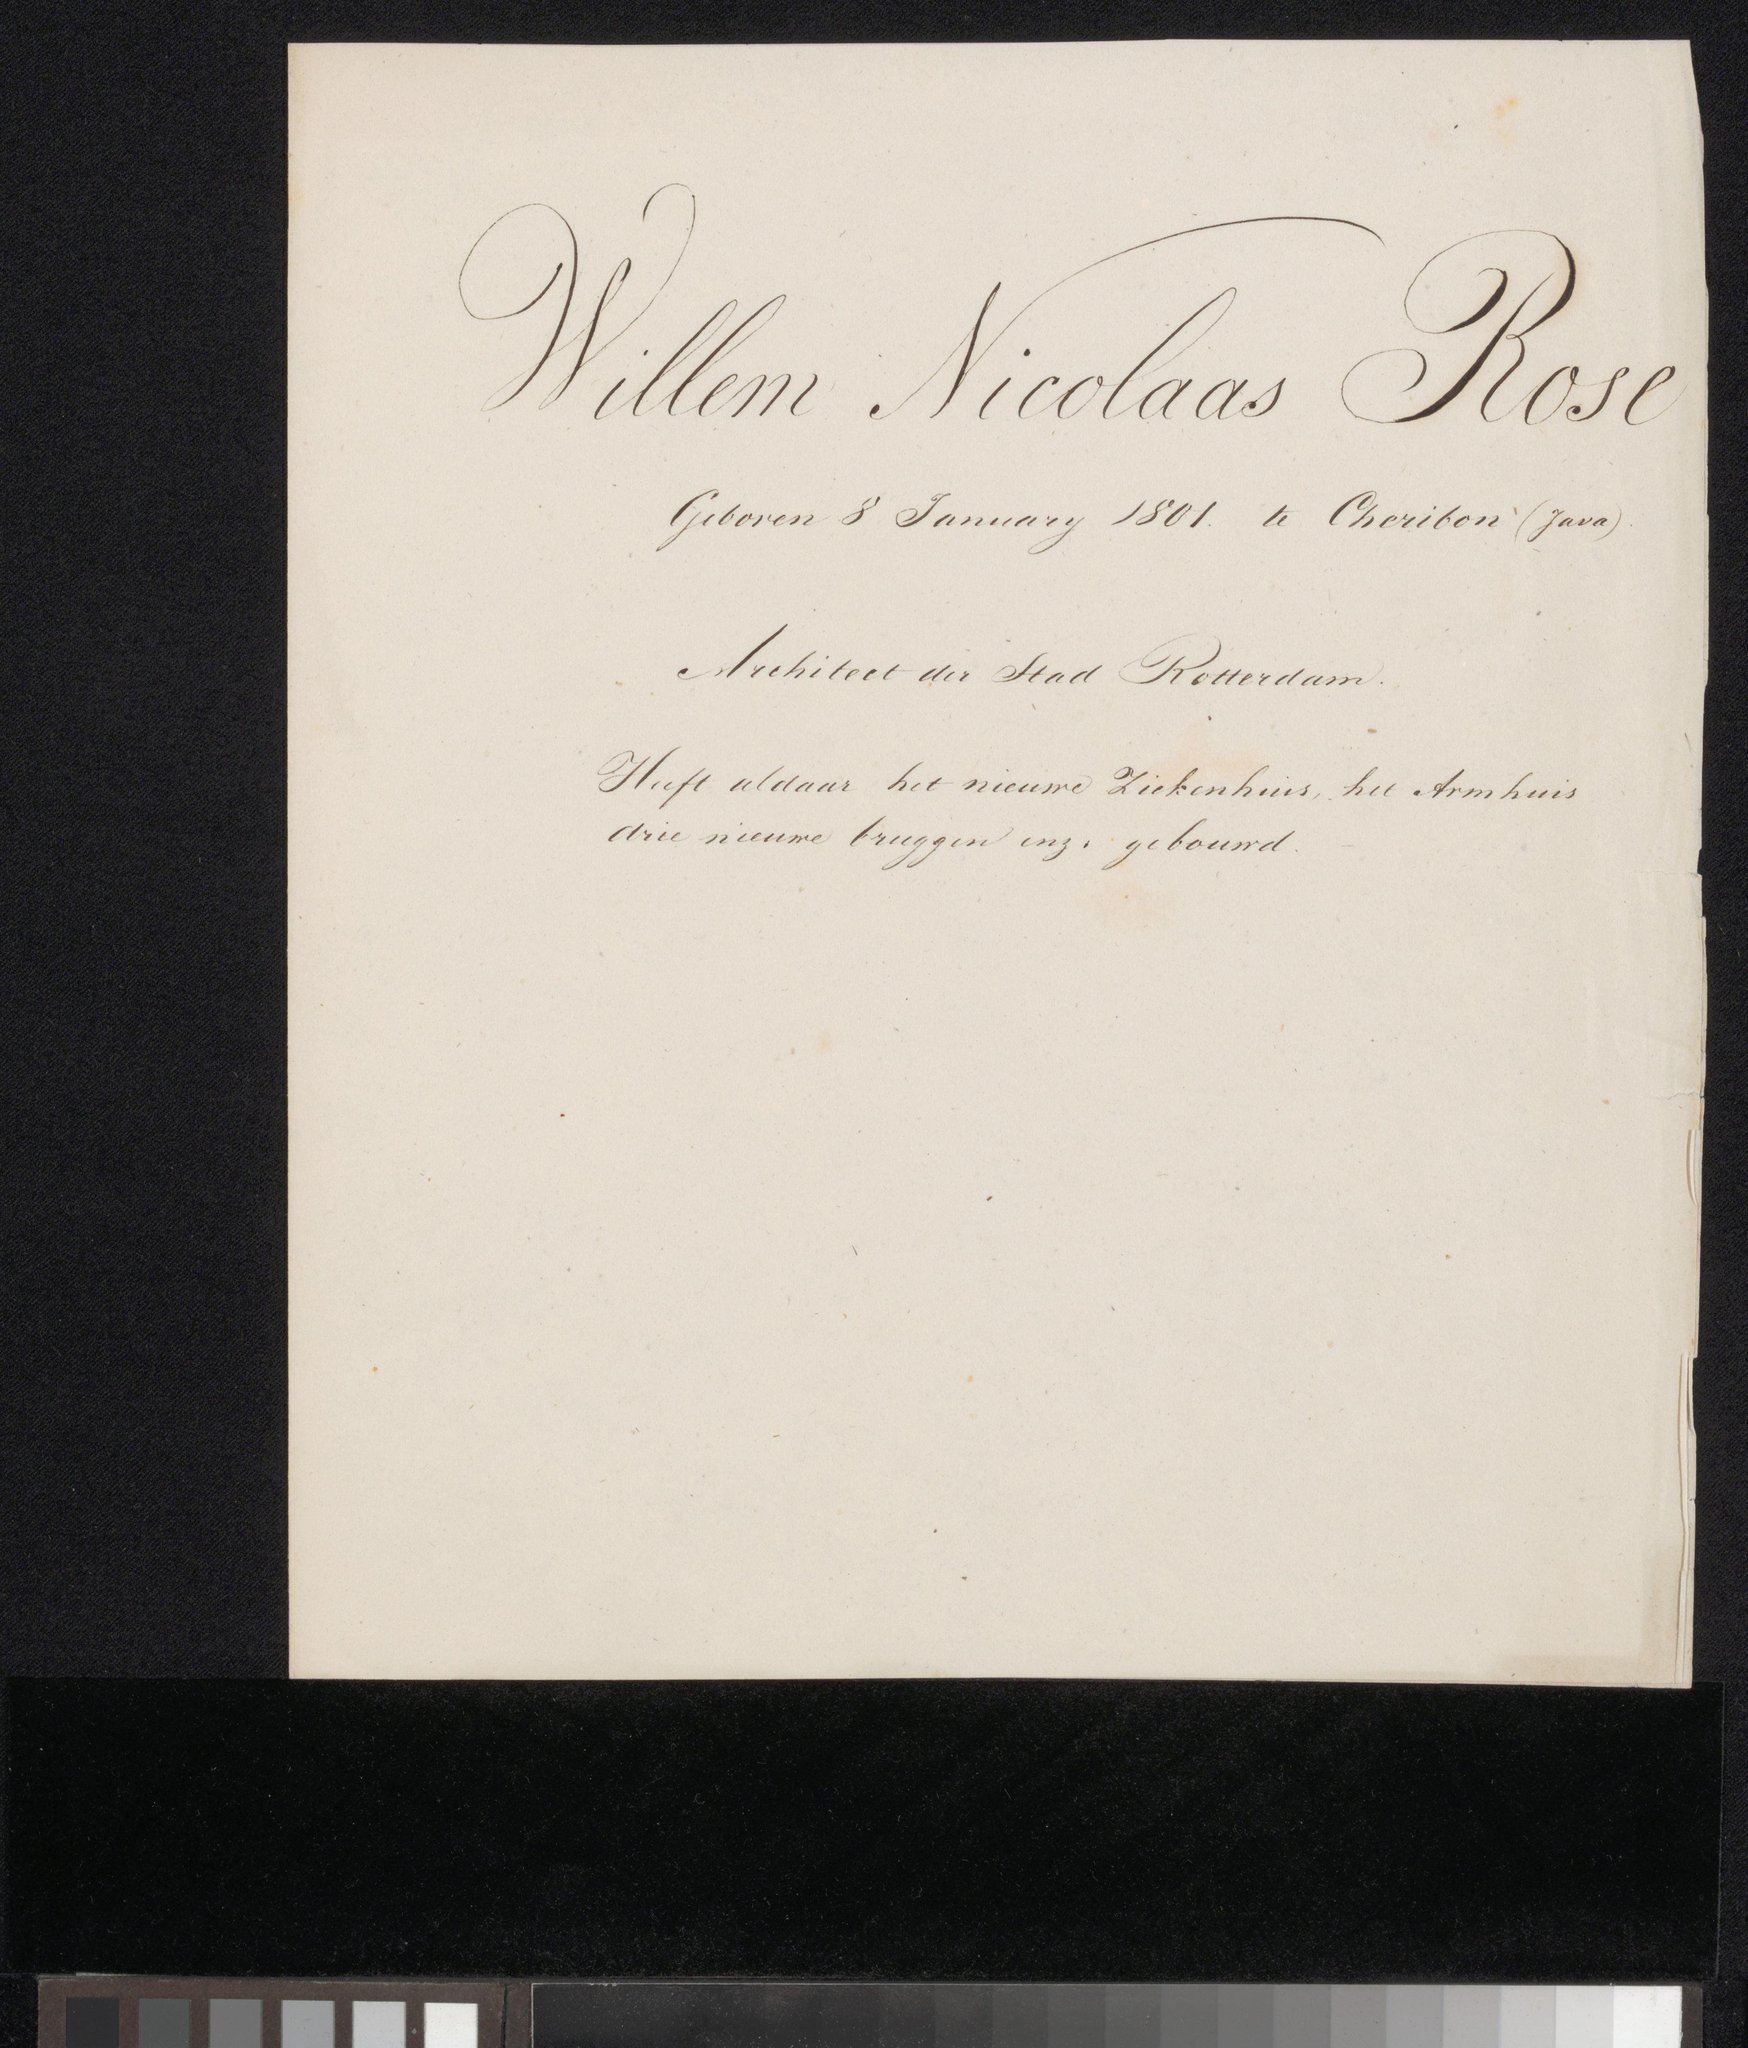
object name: document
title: Document betreffende Willem Nicolaas Rose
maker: Anonymous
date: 1839-1871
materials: ink, paper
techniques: pen, writing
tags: willem nicolaas rose, architecture, rotterdam